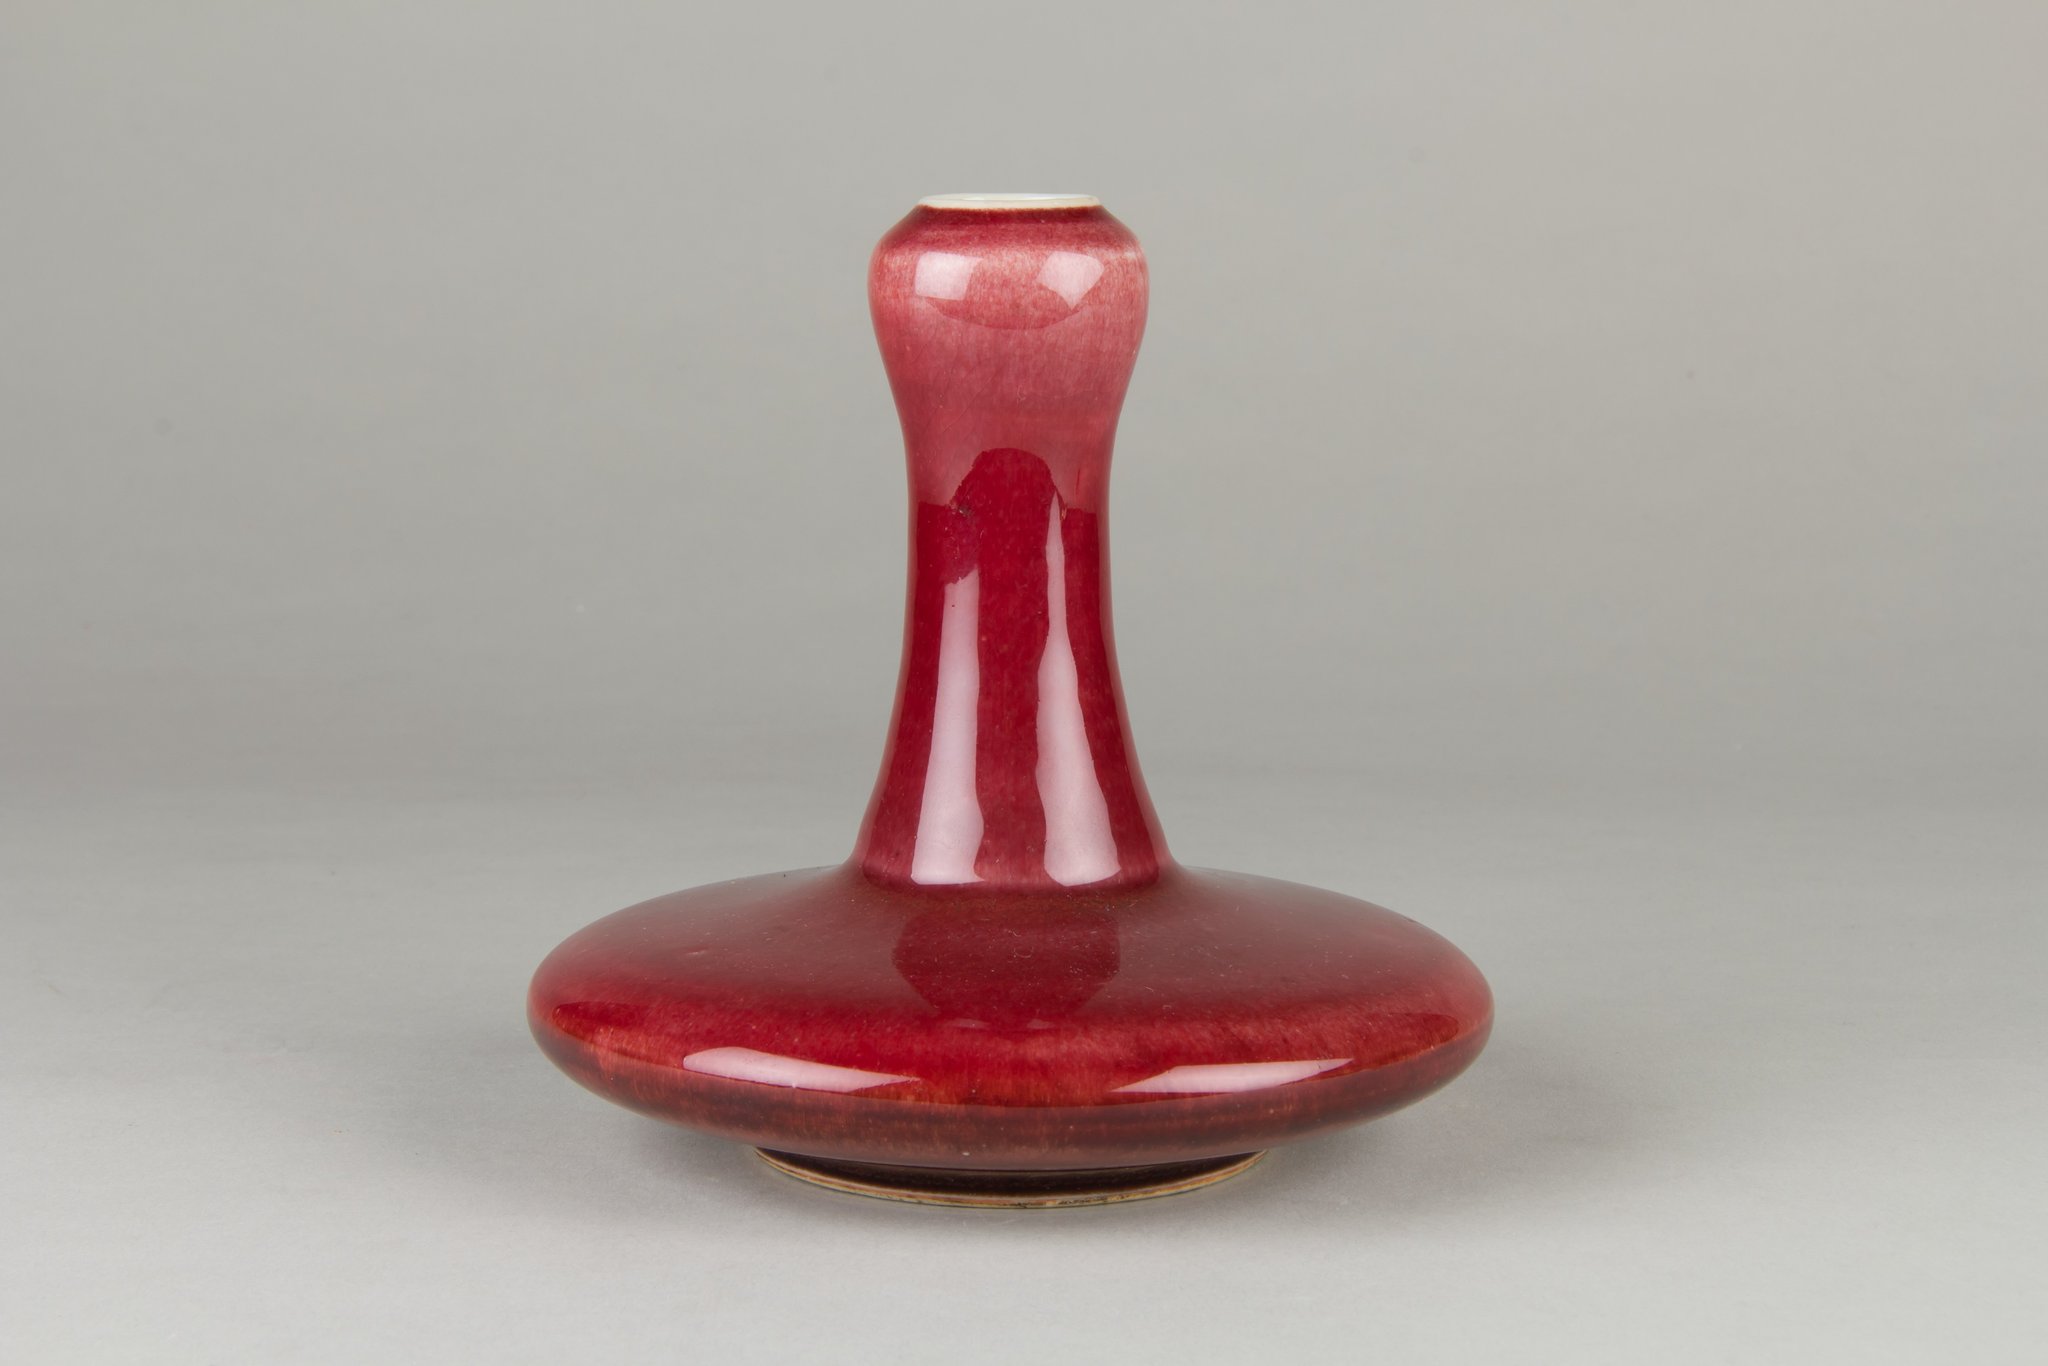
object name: bottle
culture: chinese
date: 1901-2000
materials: glaze, porcelain